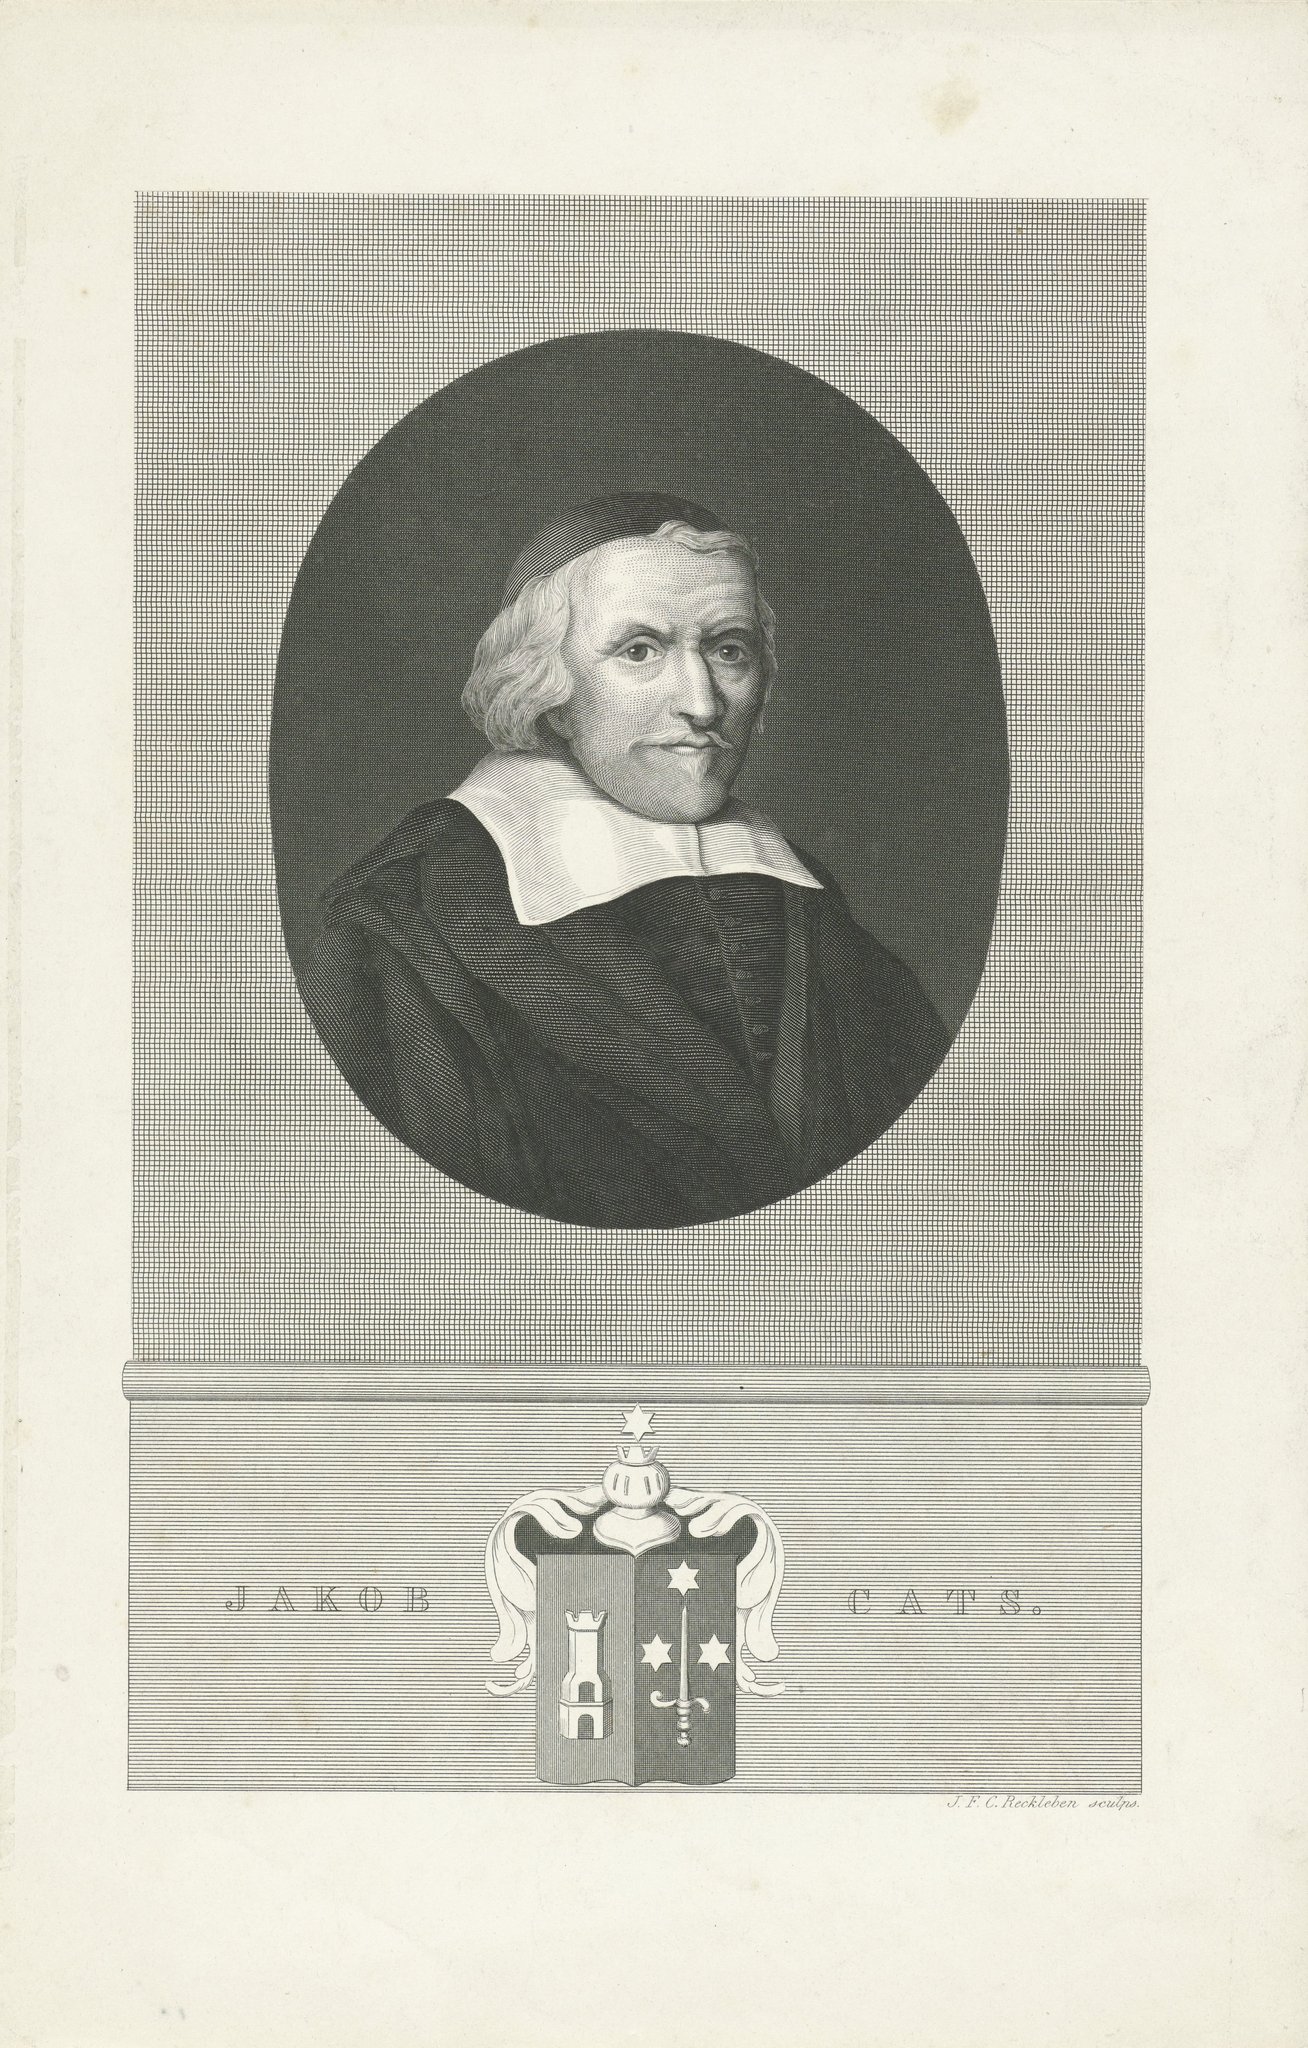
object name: print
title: Portret van Jacob Cats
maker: jan frederik christiaan reckleben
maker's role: print maker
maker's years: 1819-1879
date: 1861-1863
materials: paper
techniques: engraving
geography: amsterdam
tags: the hague, jacob cats (1577-1660)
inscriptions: collector's mark: Lugt 2228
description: Illustratie in: Arend, Johannes Pieter. Algemeene geschiedenis des vaderlands van de vroegste tijden tot op heden. 5 delen, Amsterdam: Schleijer, J.F. 1840-1884, dl. 3.4, p. 198.